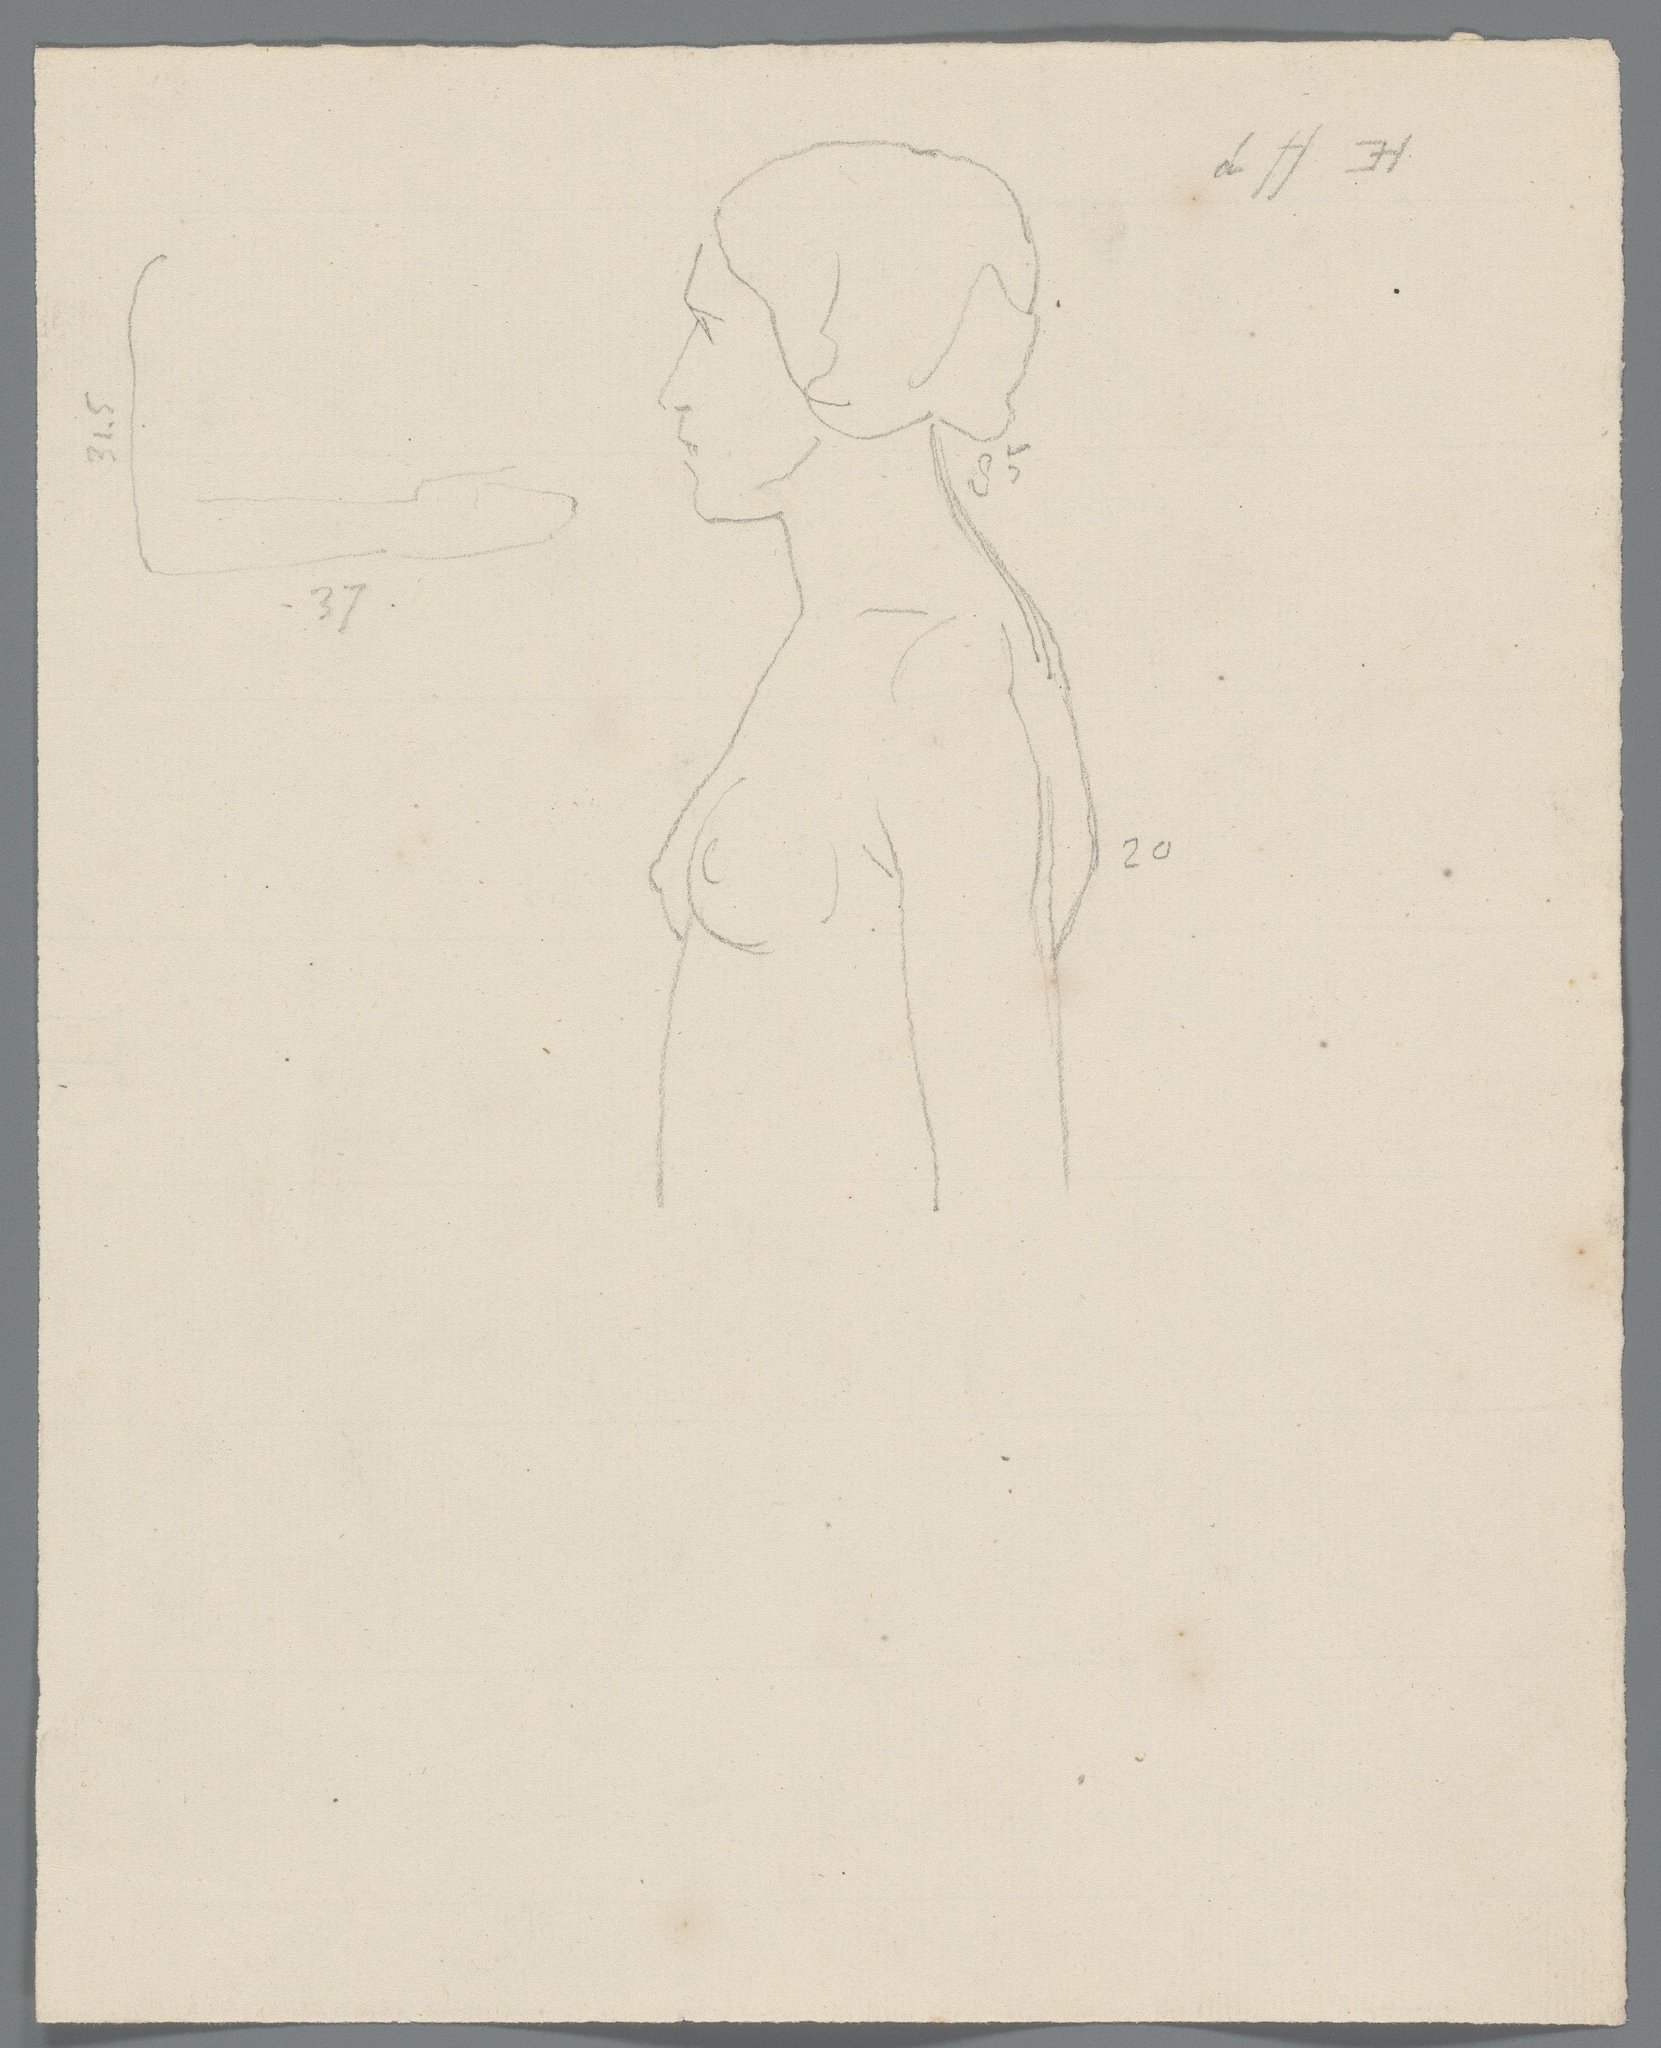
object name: drawing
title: Proportiestudie van een vrouw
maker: jacobus everhardus josephus van den berg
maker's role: draughtsman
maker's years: 1802-1861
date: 1858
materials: paper, pencil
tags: standing figure (canon, proportions) - aa - female human figure, the (nude) human figure; 'corpo humano' (ripa) - aa - female human figure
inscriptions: inscription: ‘d ff EH’